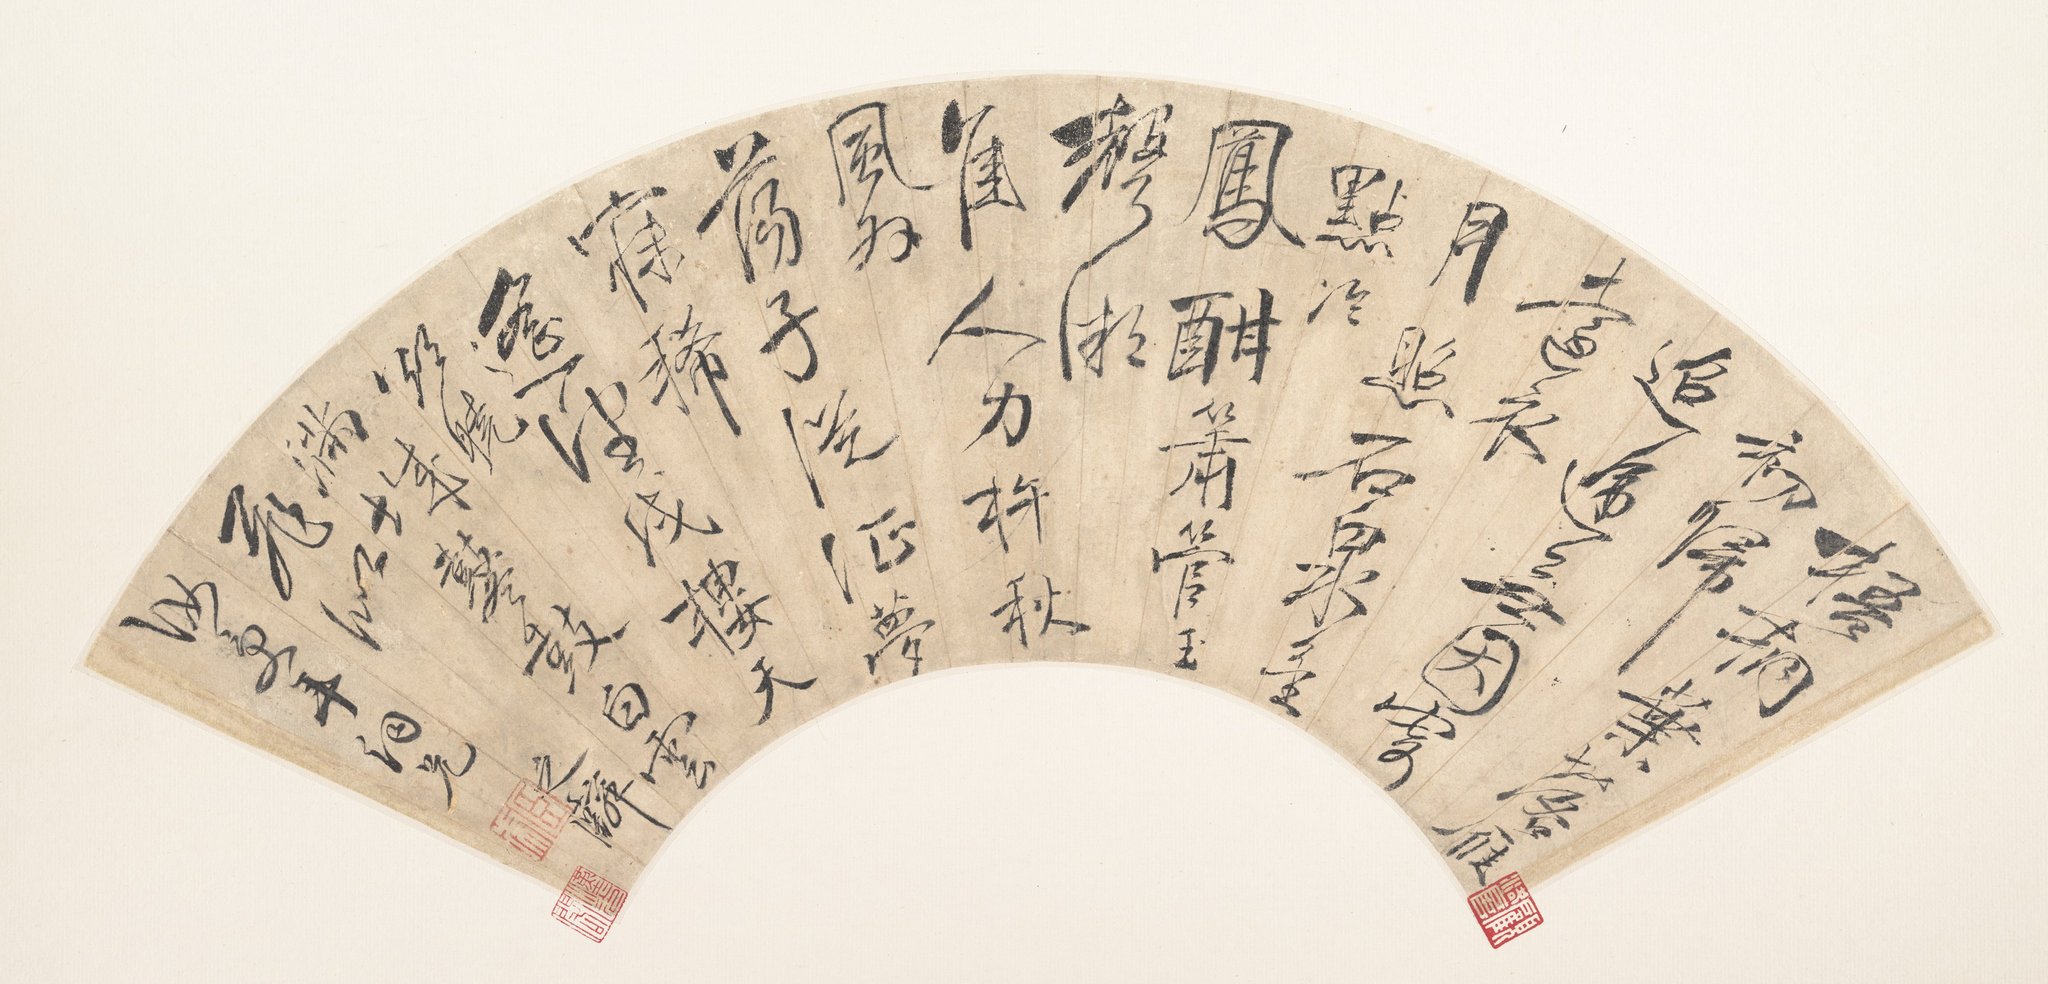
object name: folding fan mounted a an album leaf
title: Poem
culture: chinese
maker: zou zhilin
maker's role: artist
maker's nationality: chinese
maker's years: 1574-1664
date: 1574-1644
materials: ink, mica, paper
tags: poetry,calligraphy